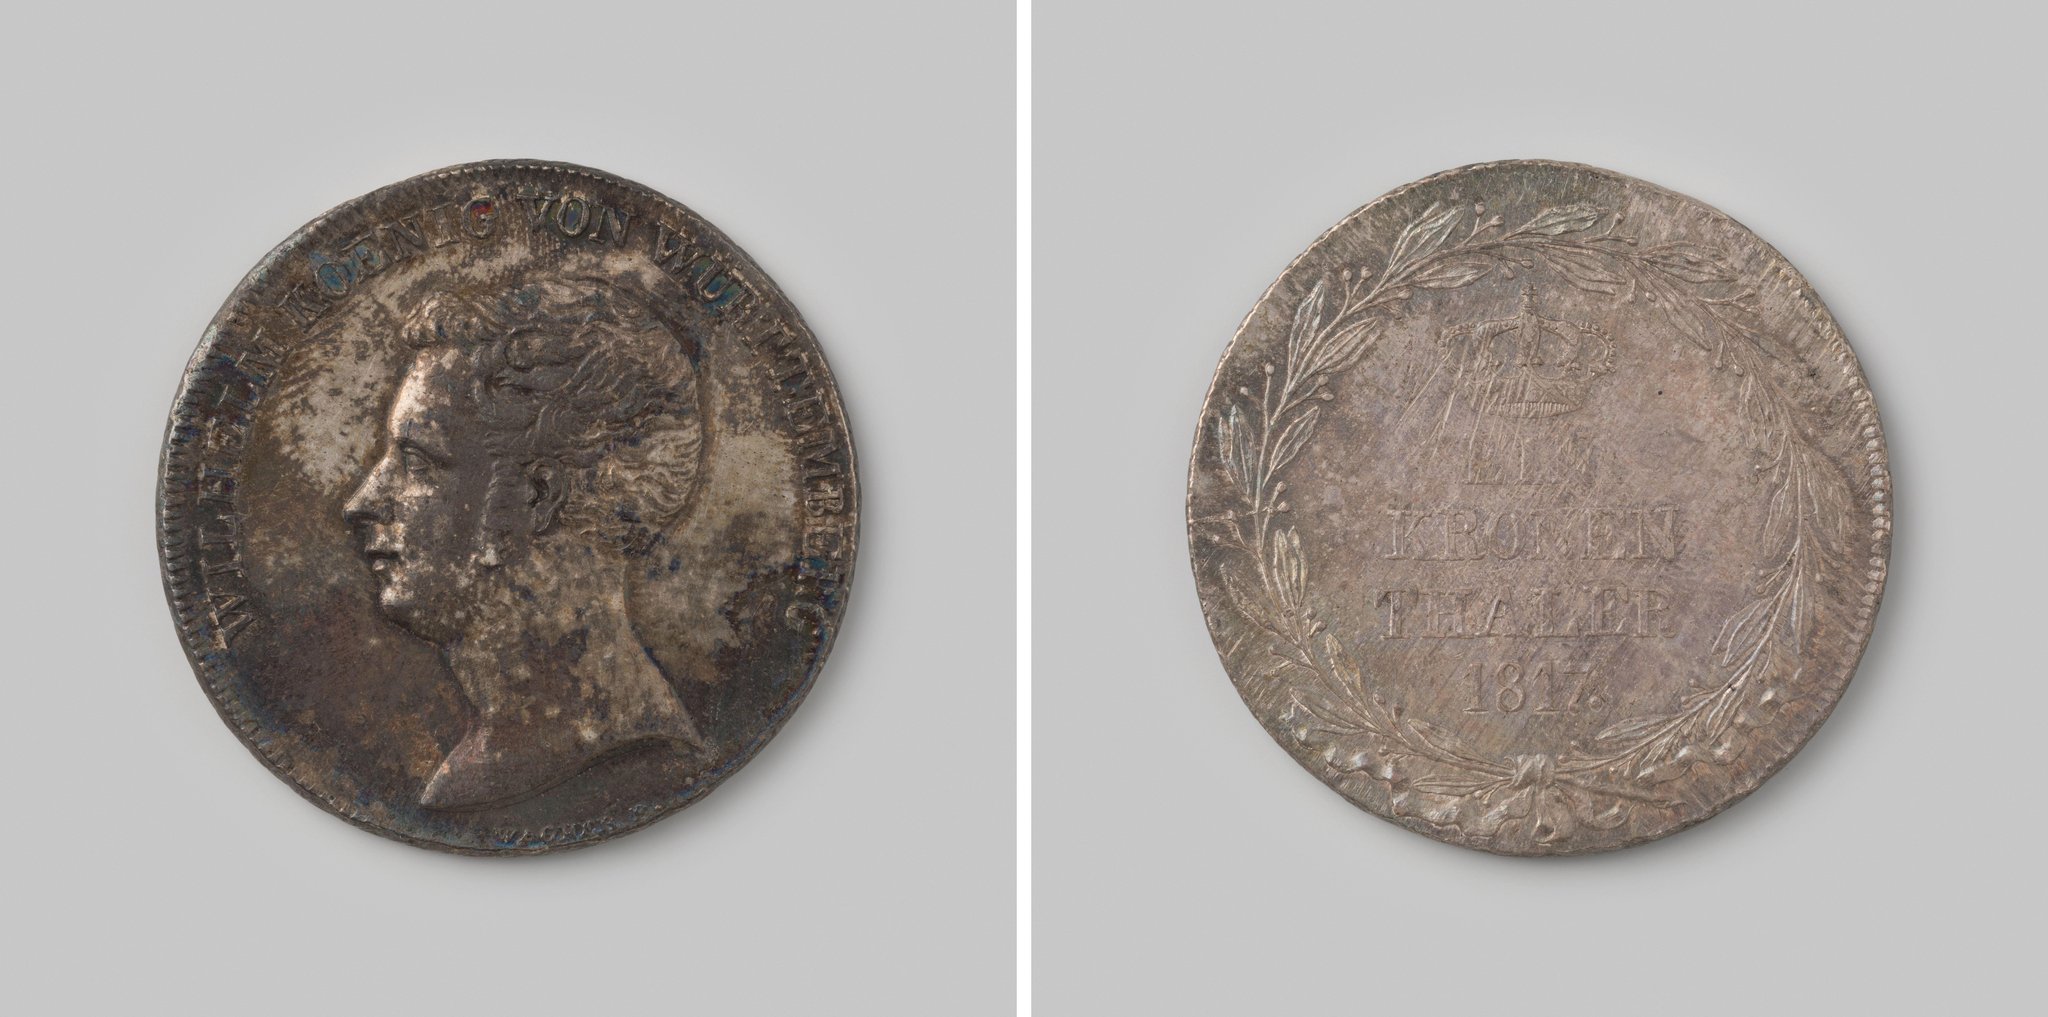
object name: coin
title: Wurtemberg, Wilhelm I, kronentaler, 1817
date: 1817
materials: silver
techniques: striking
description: Zilveren munt. Voorzijde: hoofd van de koning naar links. Keerzijde: binnen eenn lauwertak, waarvan de einden zijn samengebonden, waarde-aanduiding: Ein Kronen Thaler in drie regels, waarboven kroon en waaronder jaartal. Bloemrand.